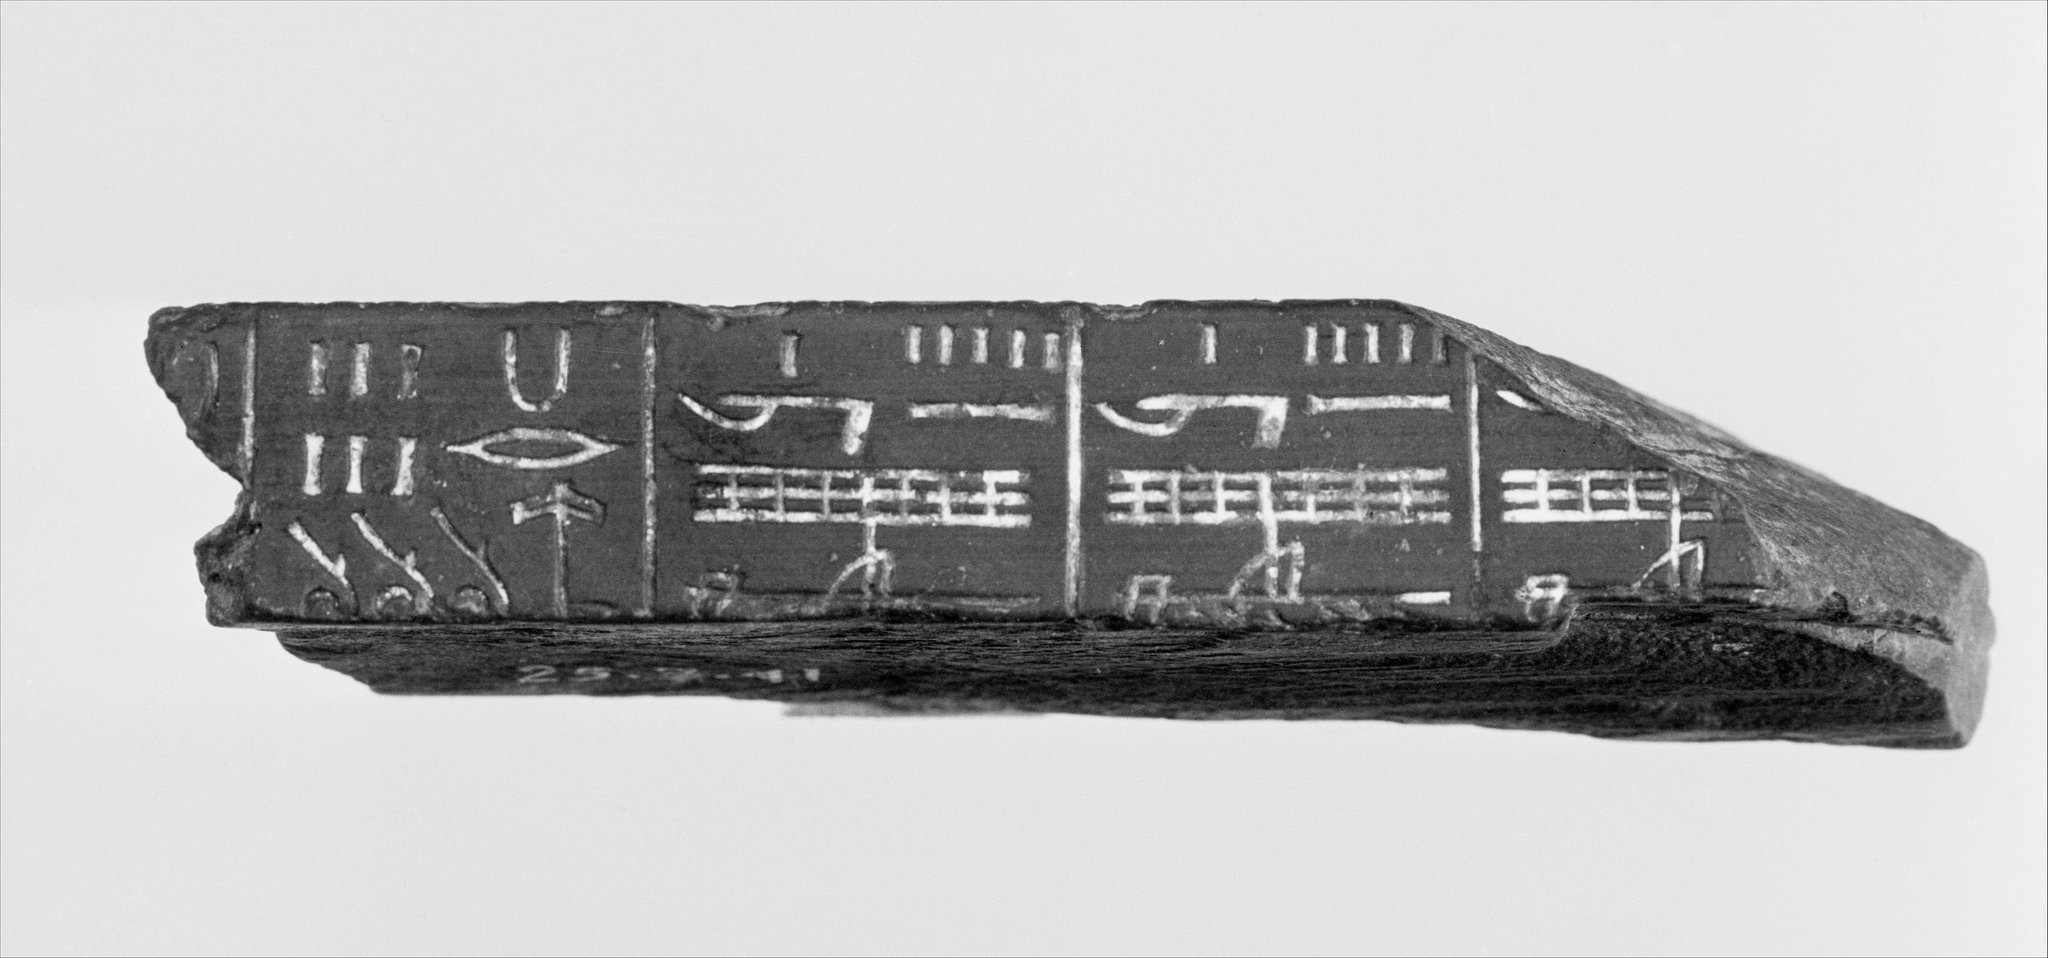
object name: cubit rod fragment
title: Fragment of a Cubit Measuring Rod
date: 1550-1295 BCE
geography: egypt